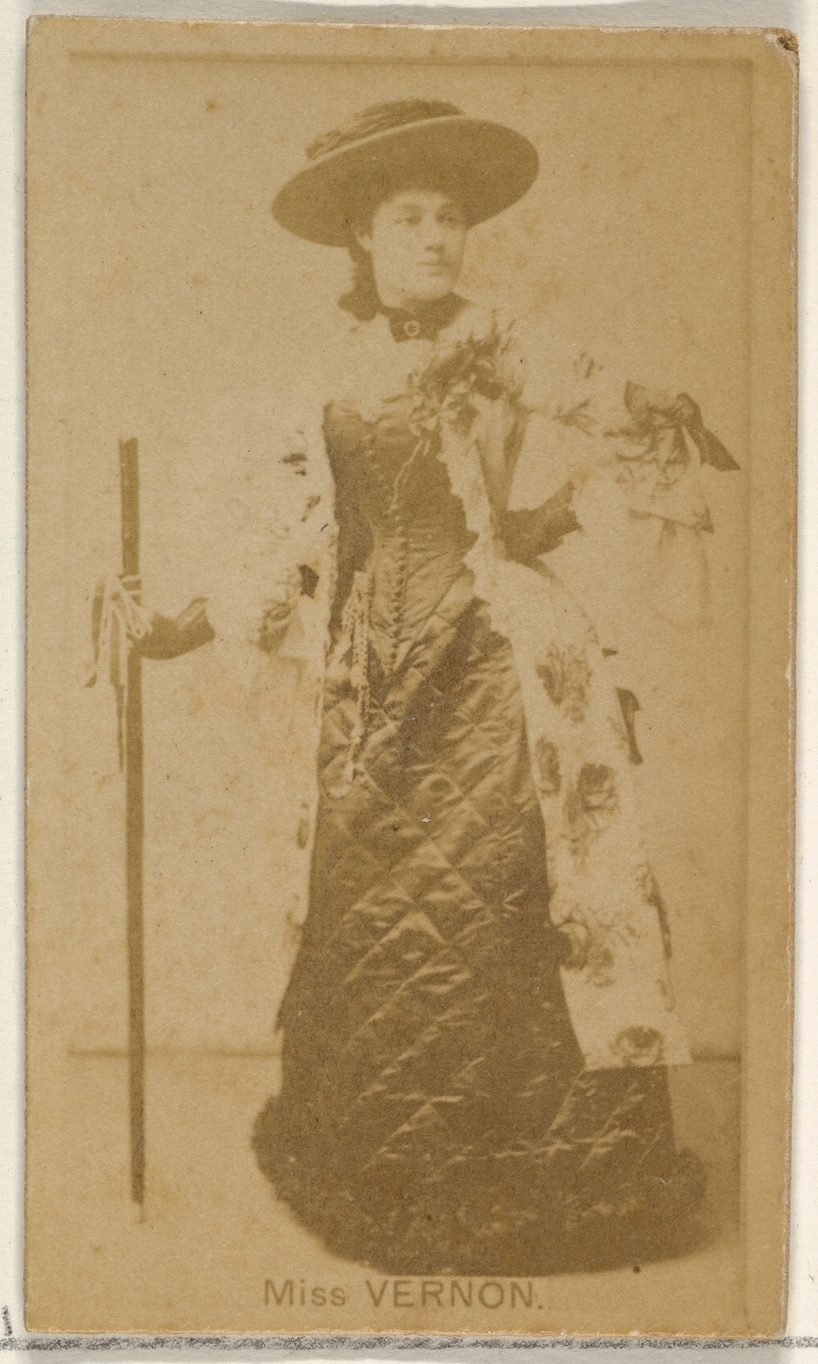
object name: photograph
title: Miss Vernon, from the Actors and Actresses series (N45, Type 8) for Virginia Brights Cigarettes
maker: allen & ginter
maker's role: publisher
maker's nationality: american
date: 1888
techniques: albumen silver print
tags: portraits,women,actresses